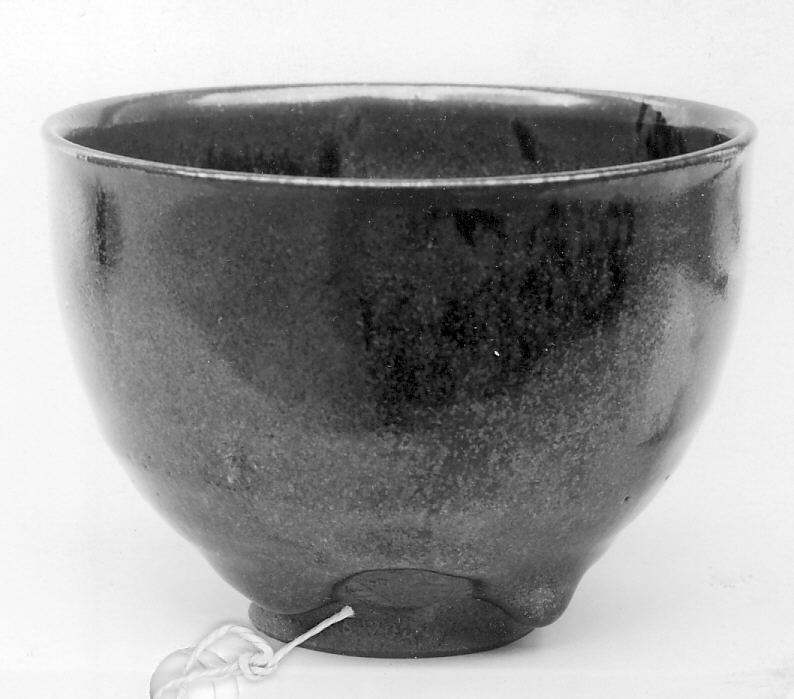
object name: teabowl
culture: japanese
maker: eiraku wazen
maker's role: artist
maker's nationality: japanese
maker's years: 1823-1896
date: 1850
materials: clay, glaze